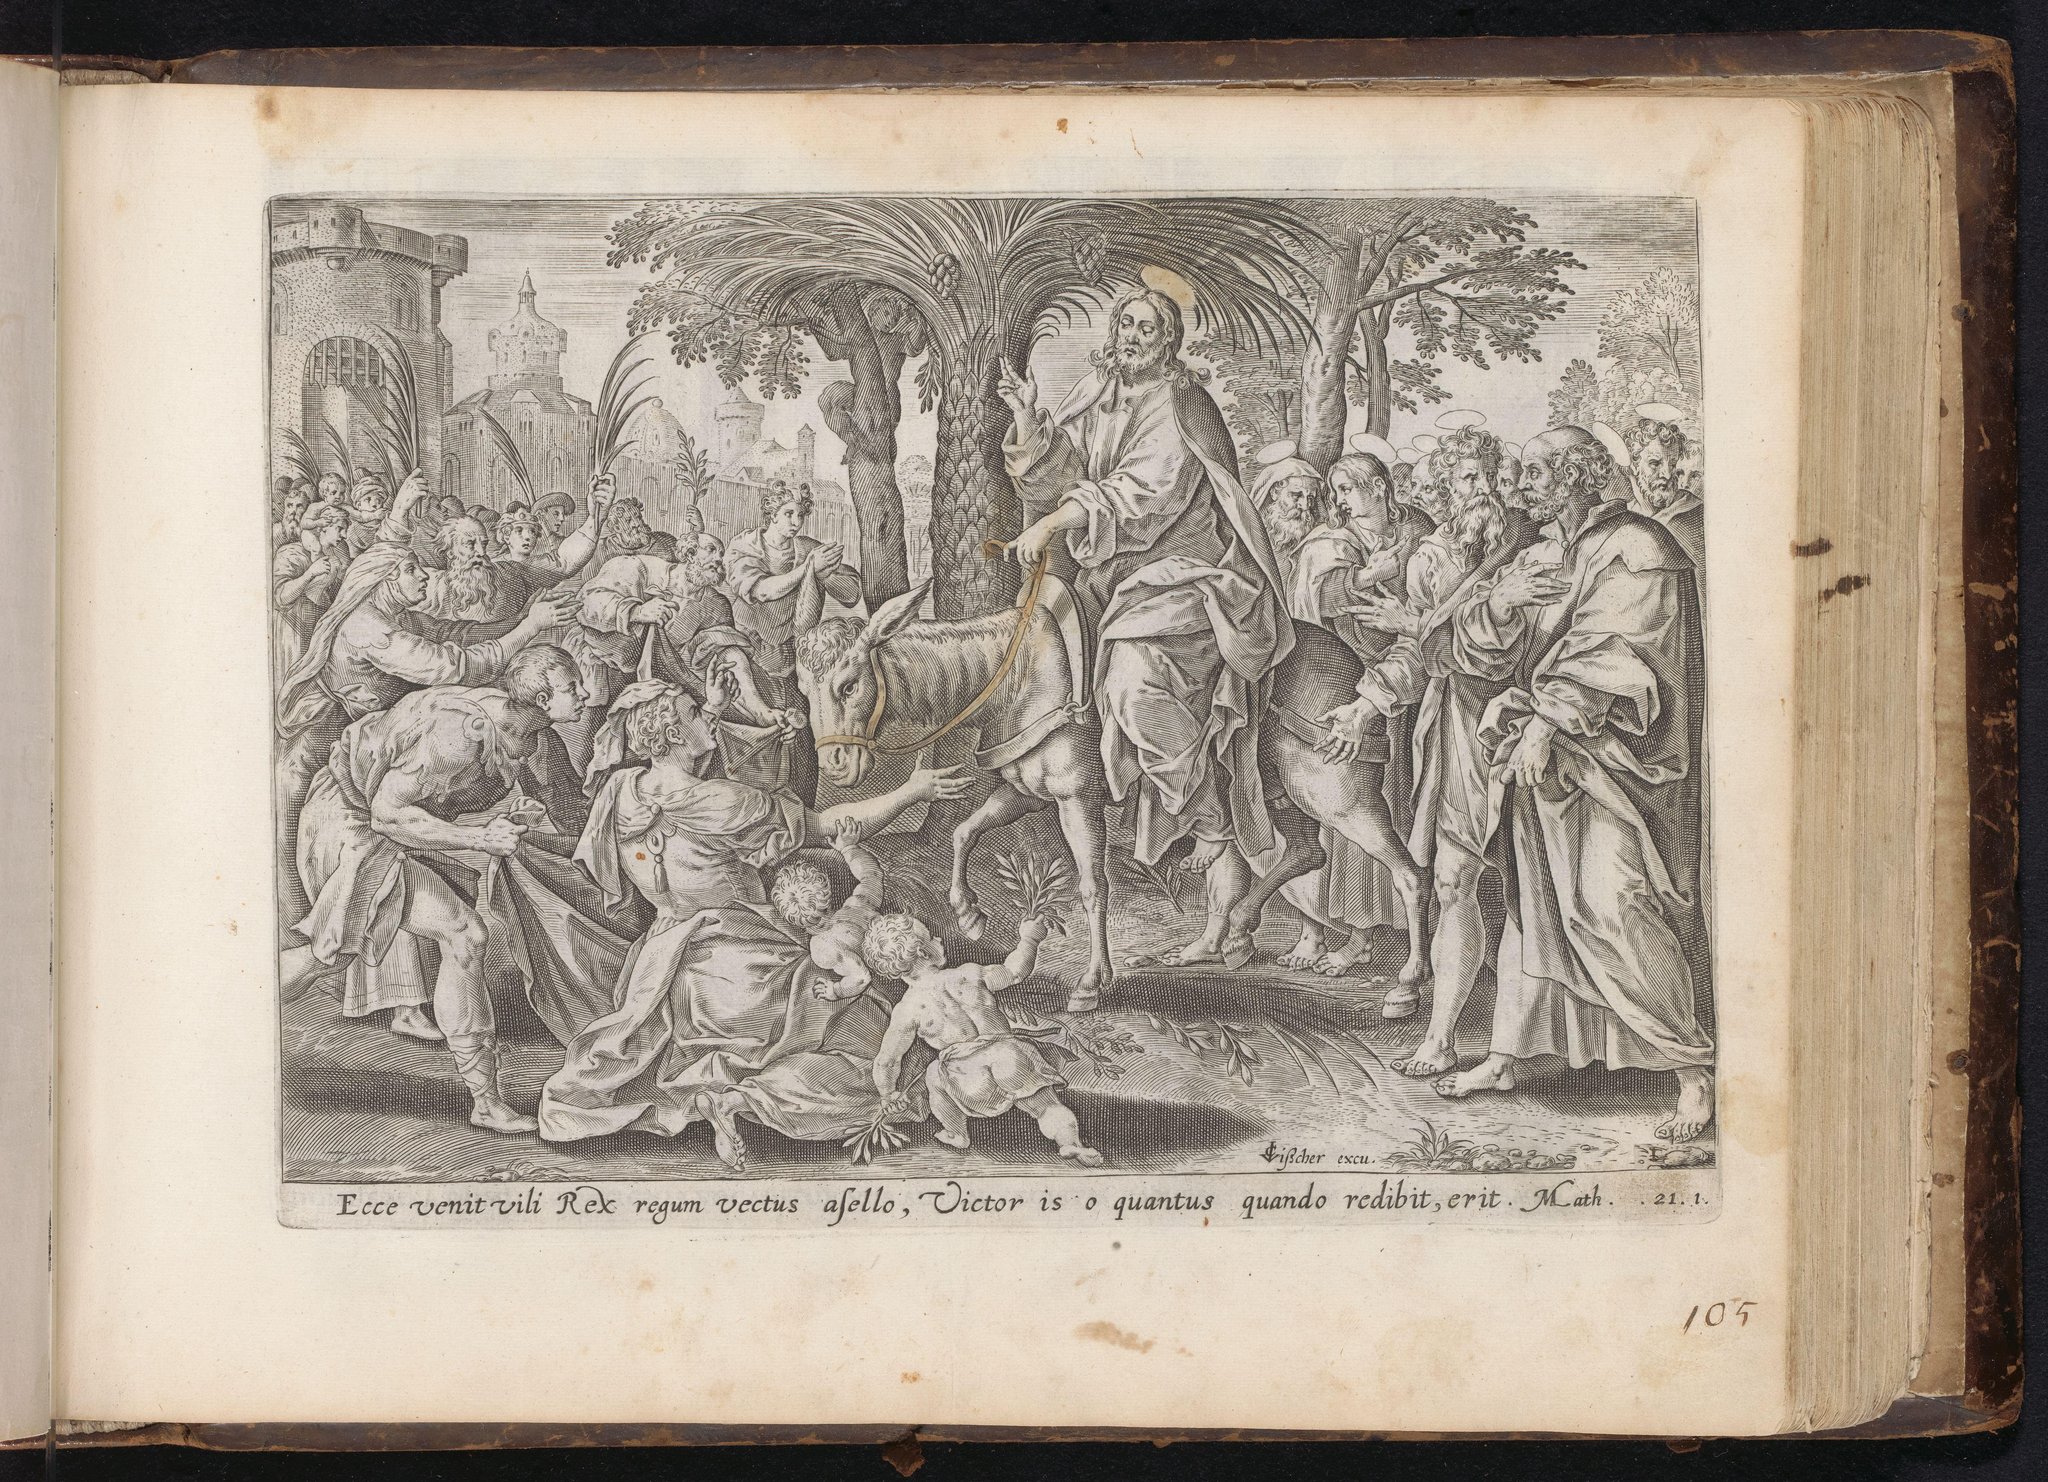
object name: print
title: Gebeurtenissen uit het leven van Christus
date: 1585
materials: paper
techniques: engraving, hand coloring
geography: alkmaar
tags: entry into jerusalem: people spreading their clothes before christ on the ass, and waving palm branches (matthew 21:1-11, 21:14-16; mark 11:1-11; luke 19:28-40; john 12:12-19)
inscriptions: number: ‘105’, serial number: ‘1’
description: Christus rijdt op een ezel Jeruzalem binnen. De menigte zwaait met palmtakken en legt kleden en mantels voor hem op de grond. Achter Christus lopen zijn apostelen. Onder de voorstelling een verwijzing in het Latijn naar de Bijbeltekst in Mat. 21:1. Deze prent maakt deel uit van een album.